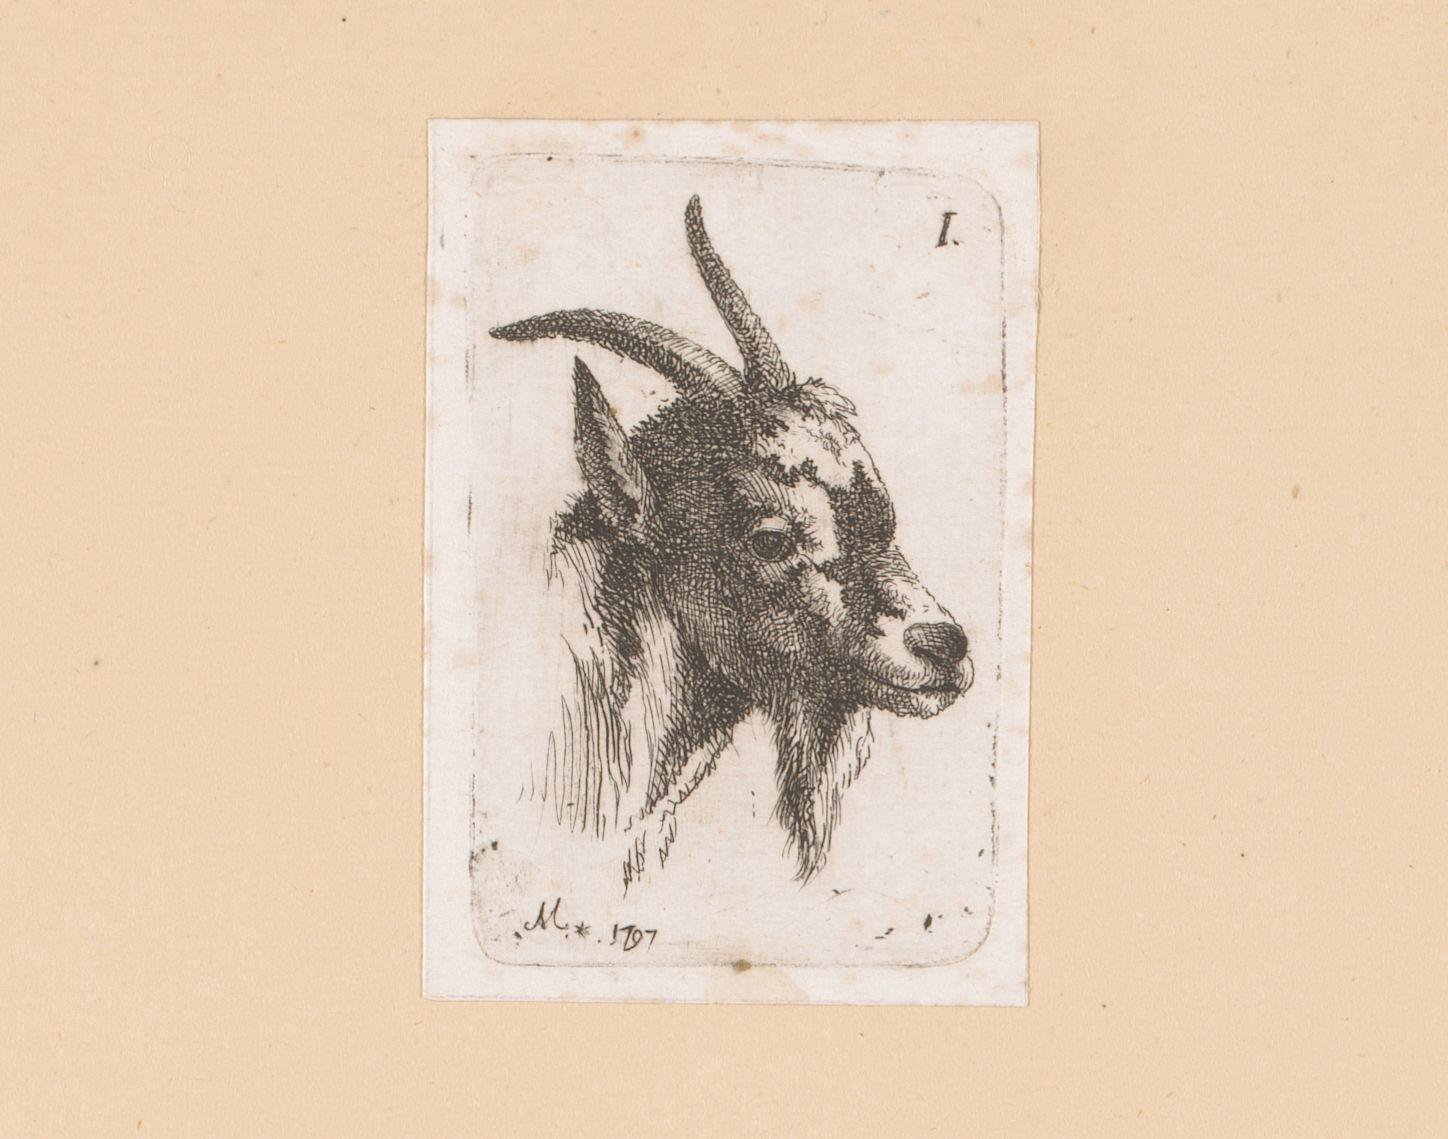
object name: print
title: Kop van een geit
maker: johann friedrich morgenstern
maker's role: print maker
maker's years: 1777-1844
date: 1797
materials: paper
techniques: etching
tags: goat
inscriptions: collector's mark: Lugt 2228